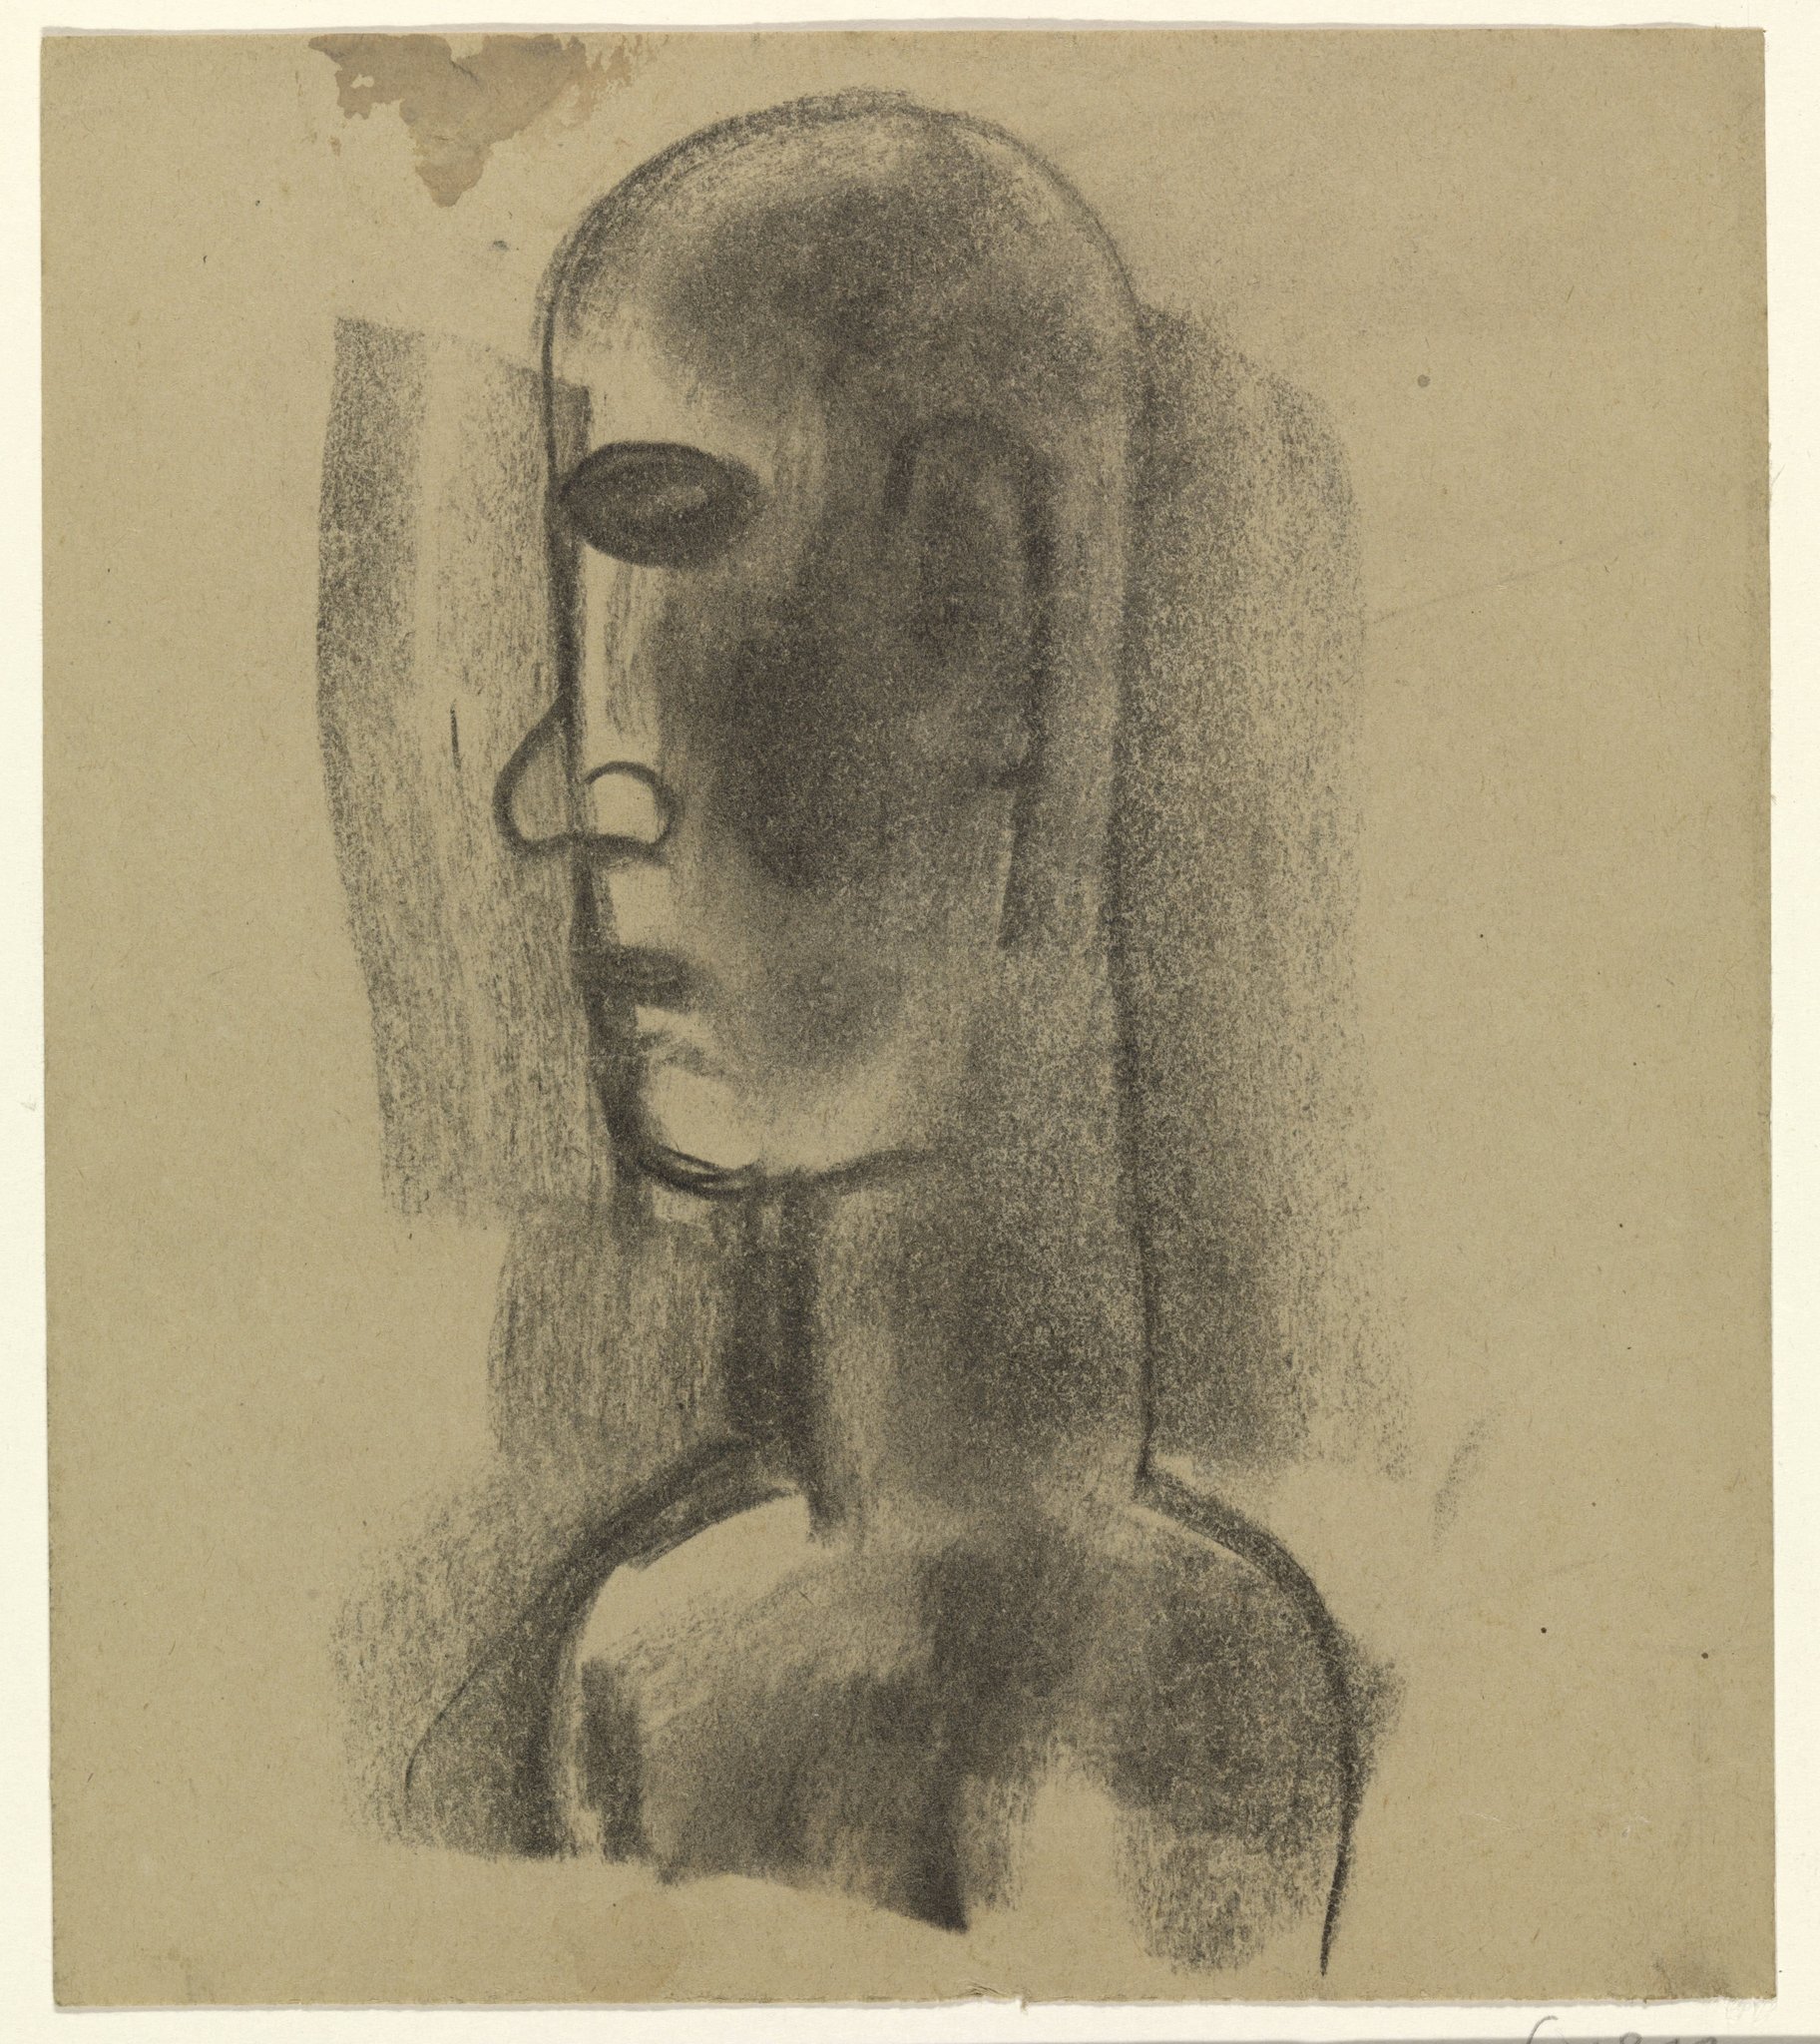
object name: drawing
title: Mannenhoofd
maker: leo gestel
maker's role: draughtsman, print maker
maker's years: 1881-1941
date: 1891-1941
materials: charcoal, paper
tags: face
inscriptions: collector's mark: Lugt 2228